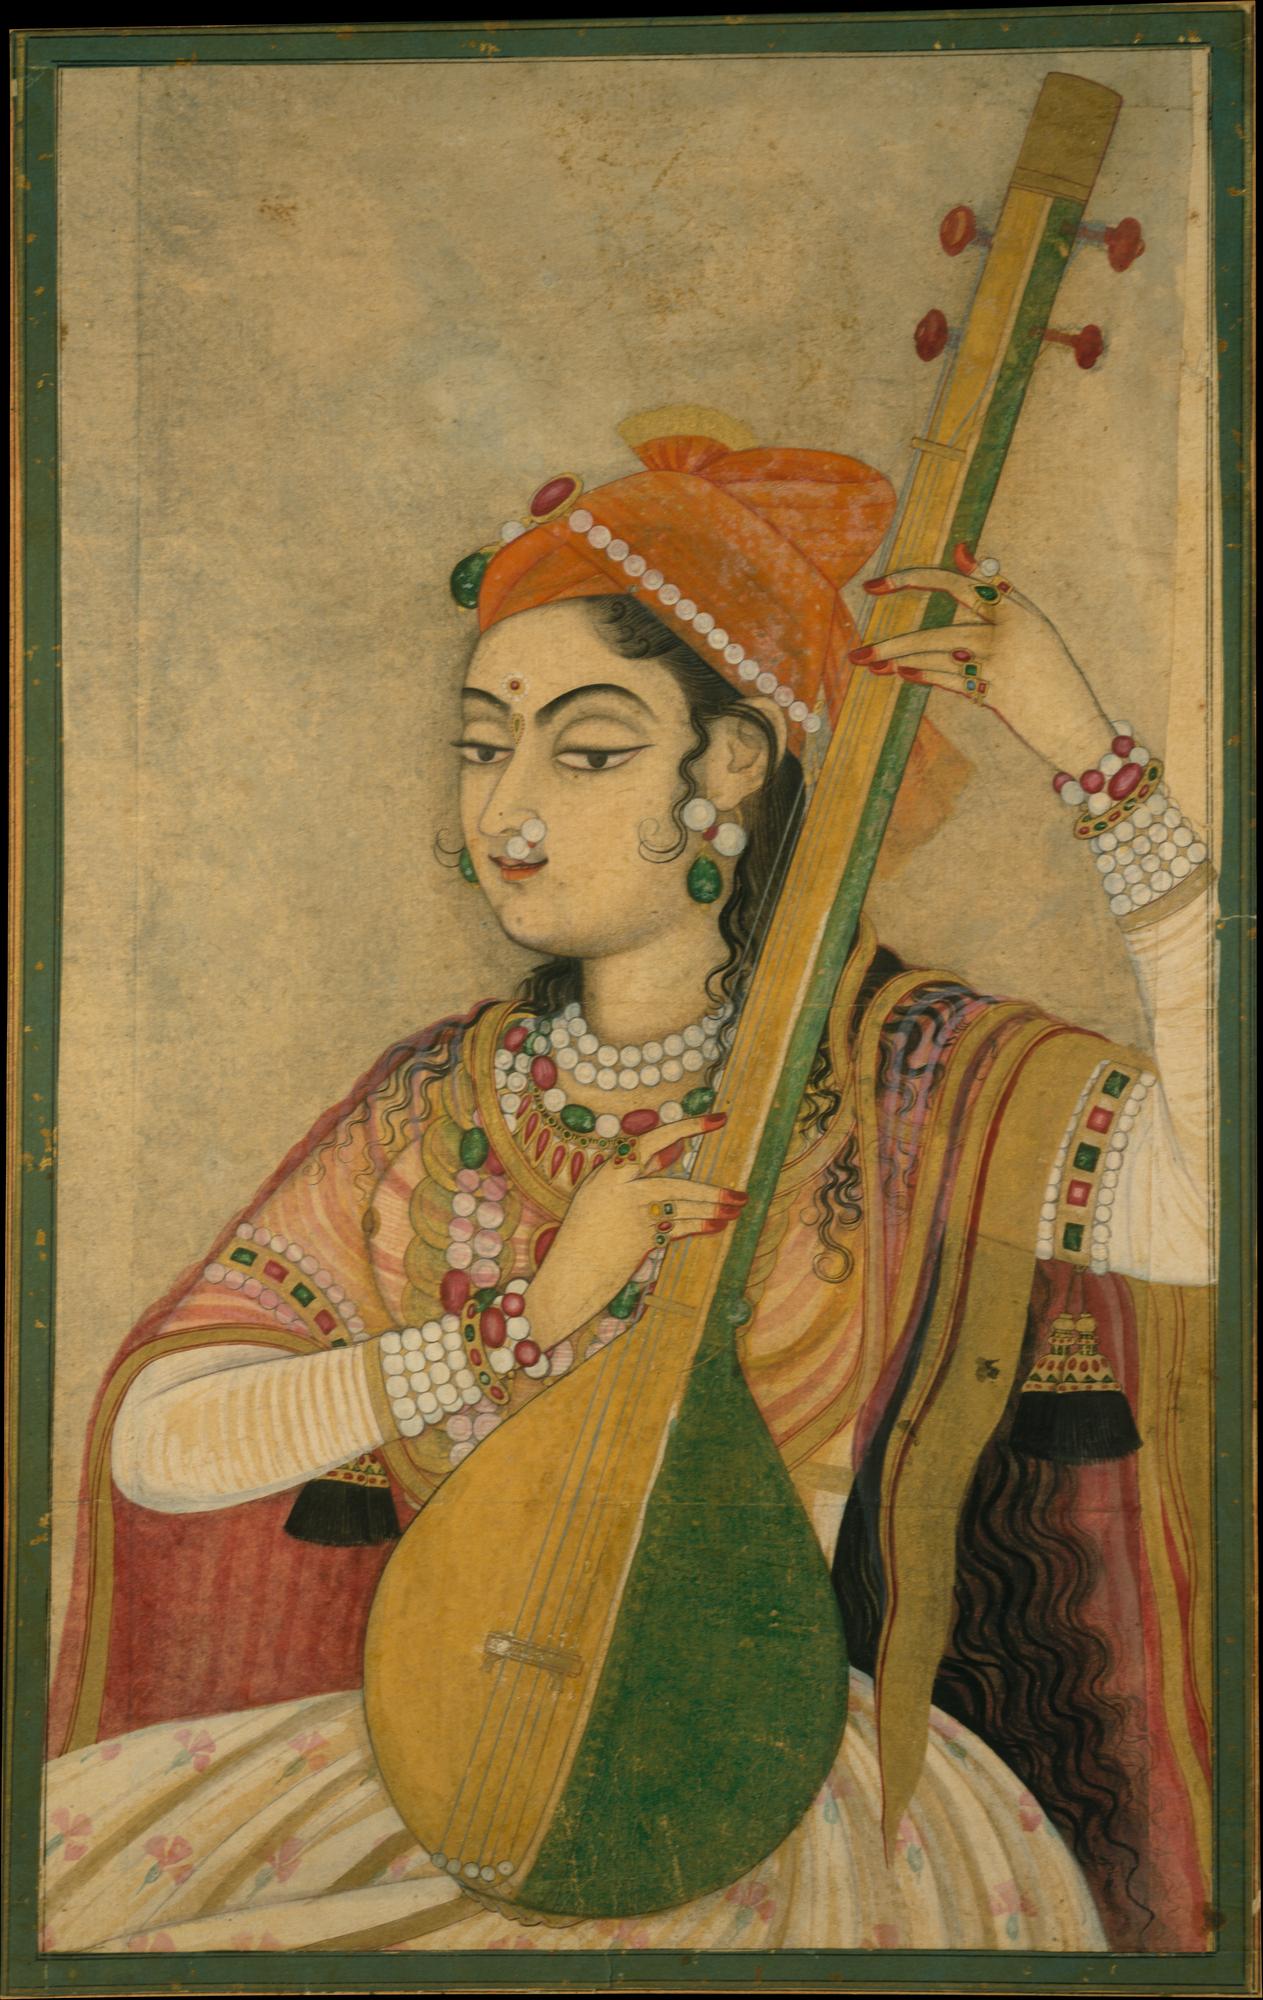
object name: painting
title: A Lady Playing the Tanpura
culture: indian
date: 1735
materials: gold, ink, paper, watercolor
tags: musical instruments,women,music,musicians